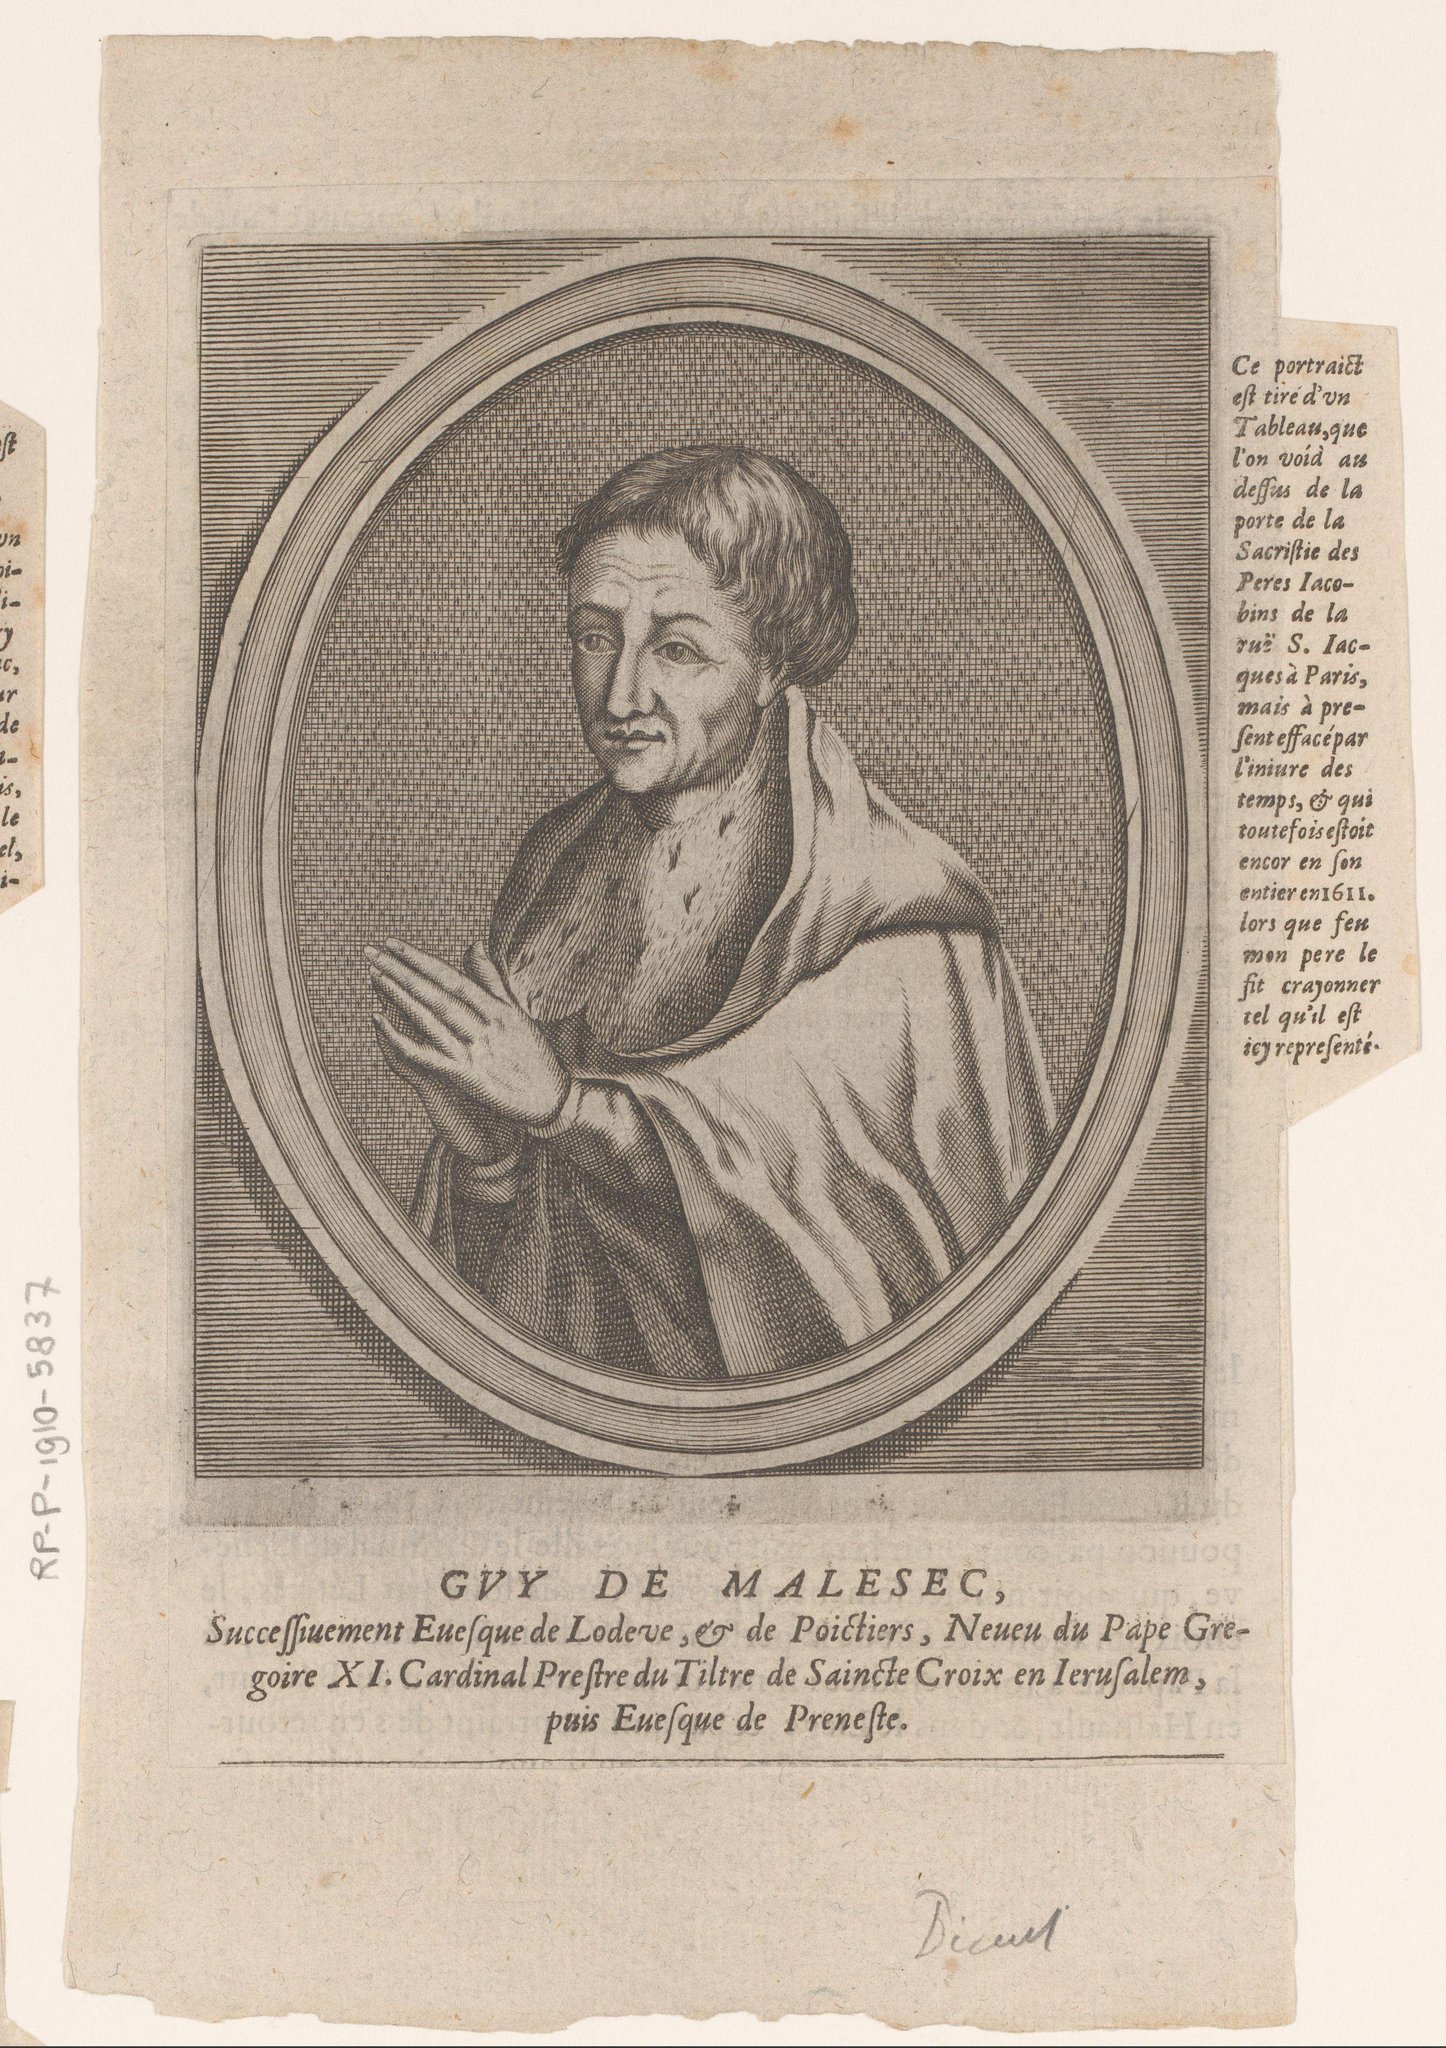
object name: book illustration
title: Portret van Guy de Malesec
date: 1660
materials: paper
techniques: engraving, etching, letterpress printing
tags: cardinal, historical persons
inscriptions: collector's mark: Lugt 2228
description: Prent uit: Du Chesne, François. Histoire de tous les cardinaux françois de naissance, ou qui ont esté promeus au cardinalat. Parijs: François Du Chesne, 1660.